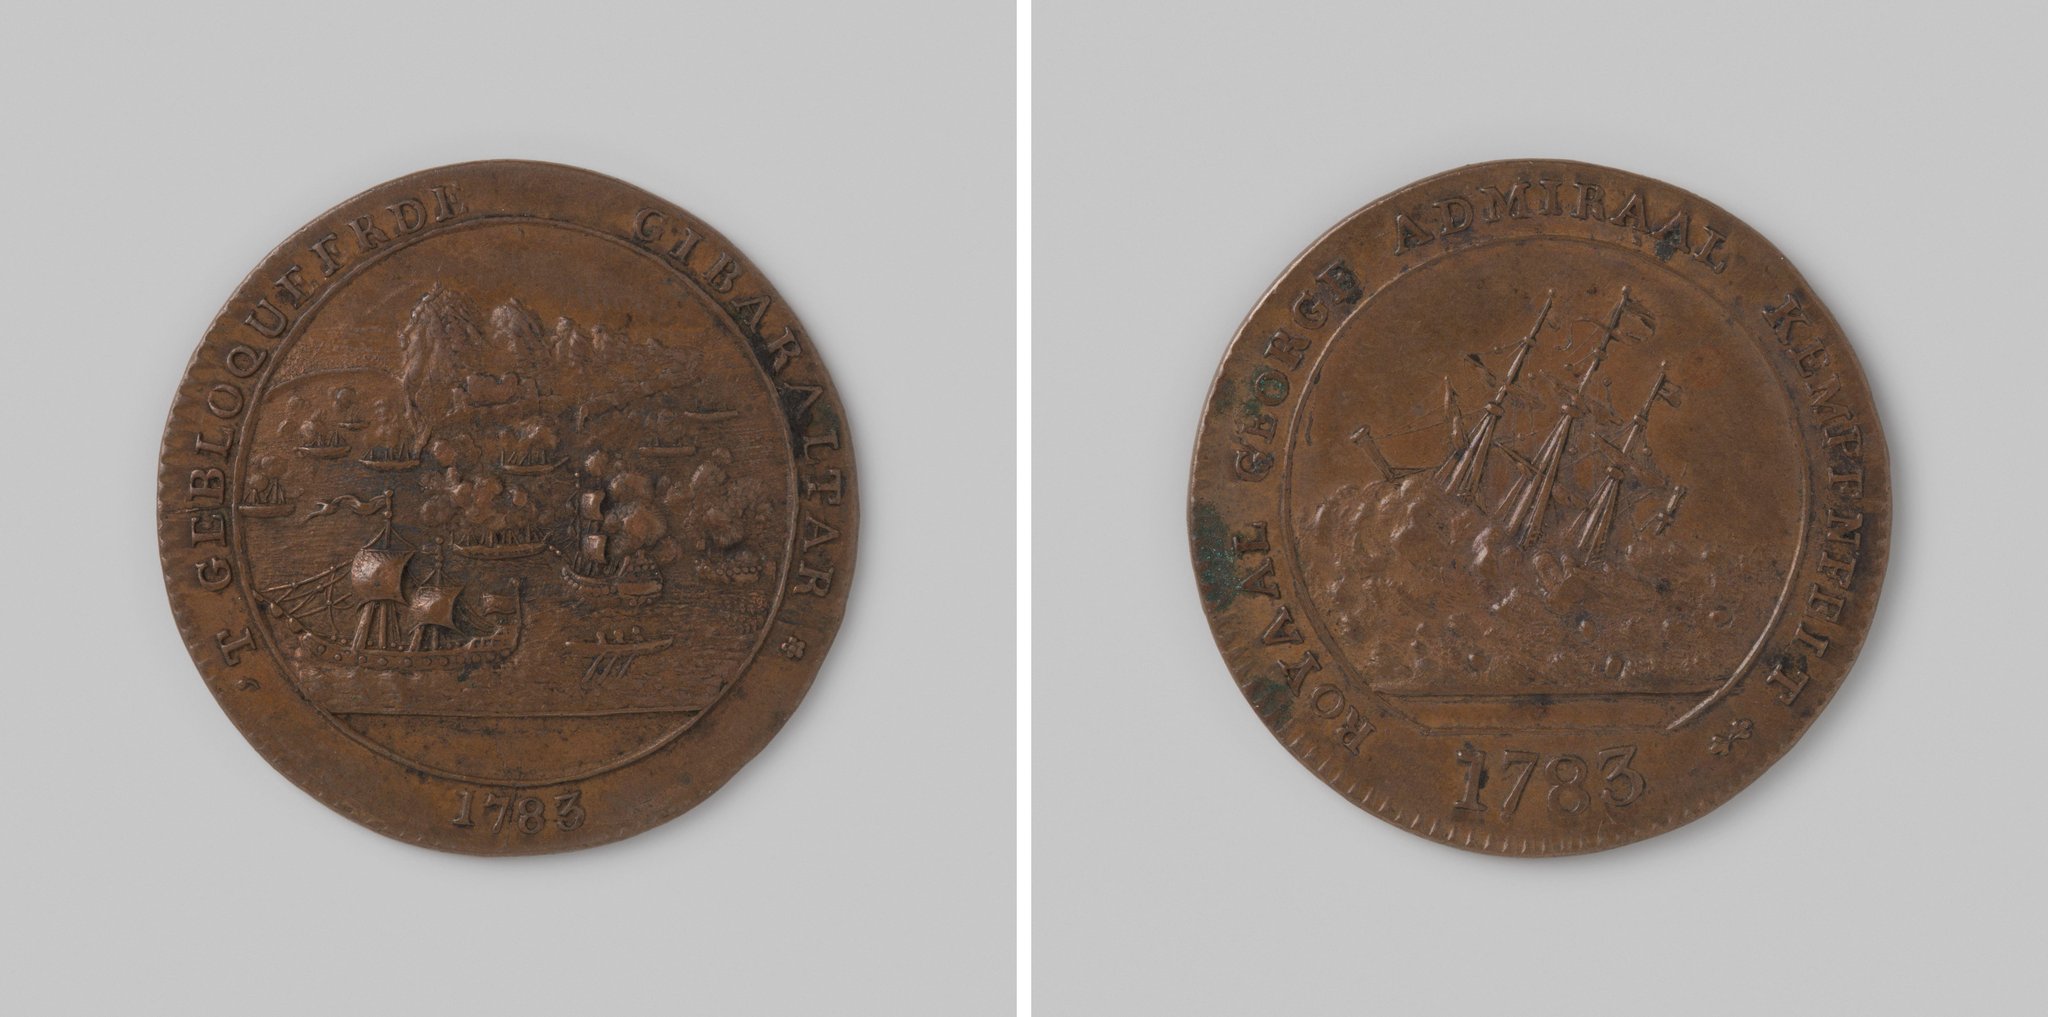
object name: history medal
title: De blokkade van Gibraltar en het zinken van de Royal George 1783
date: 1783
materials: copper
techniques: pressing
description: Koperen penning, op de voorzijde oorlogsschepen die Gibraltar beschieten, met omschrift, op de keerzijde een zinkende driemaster, met omschrift.